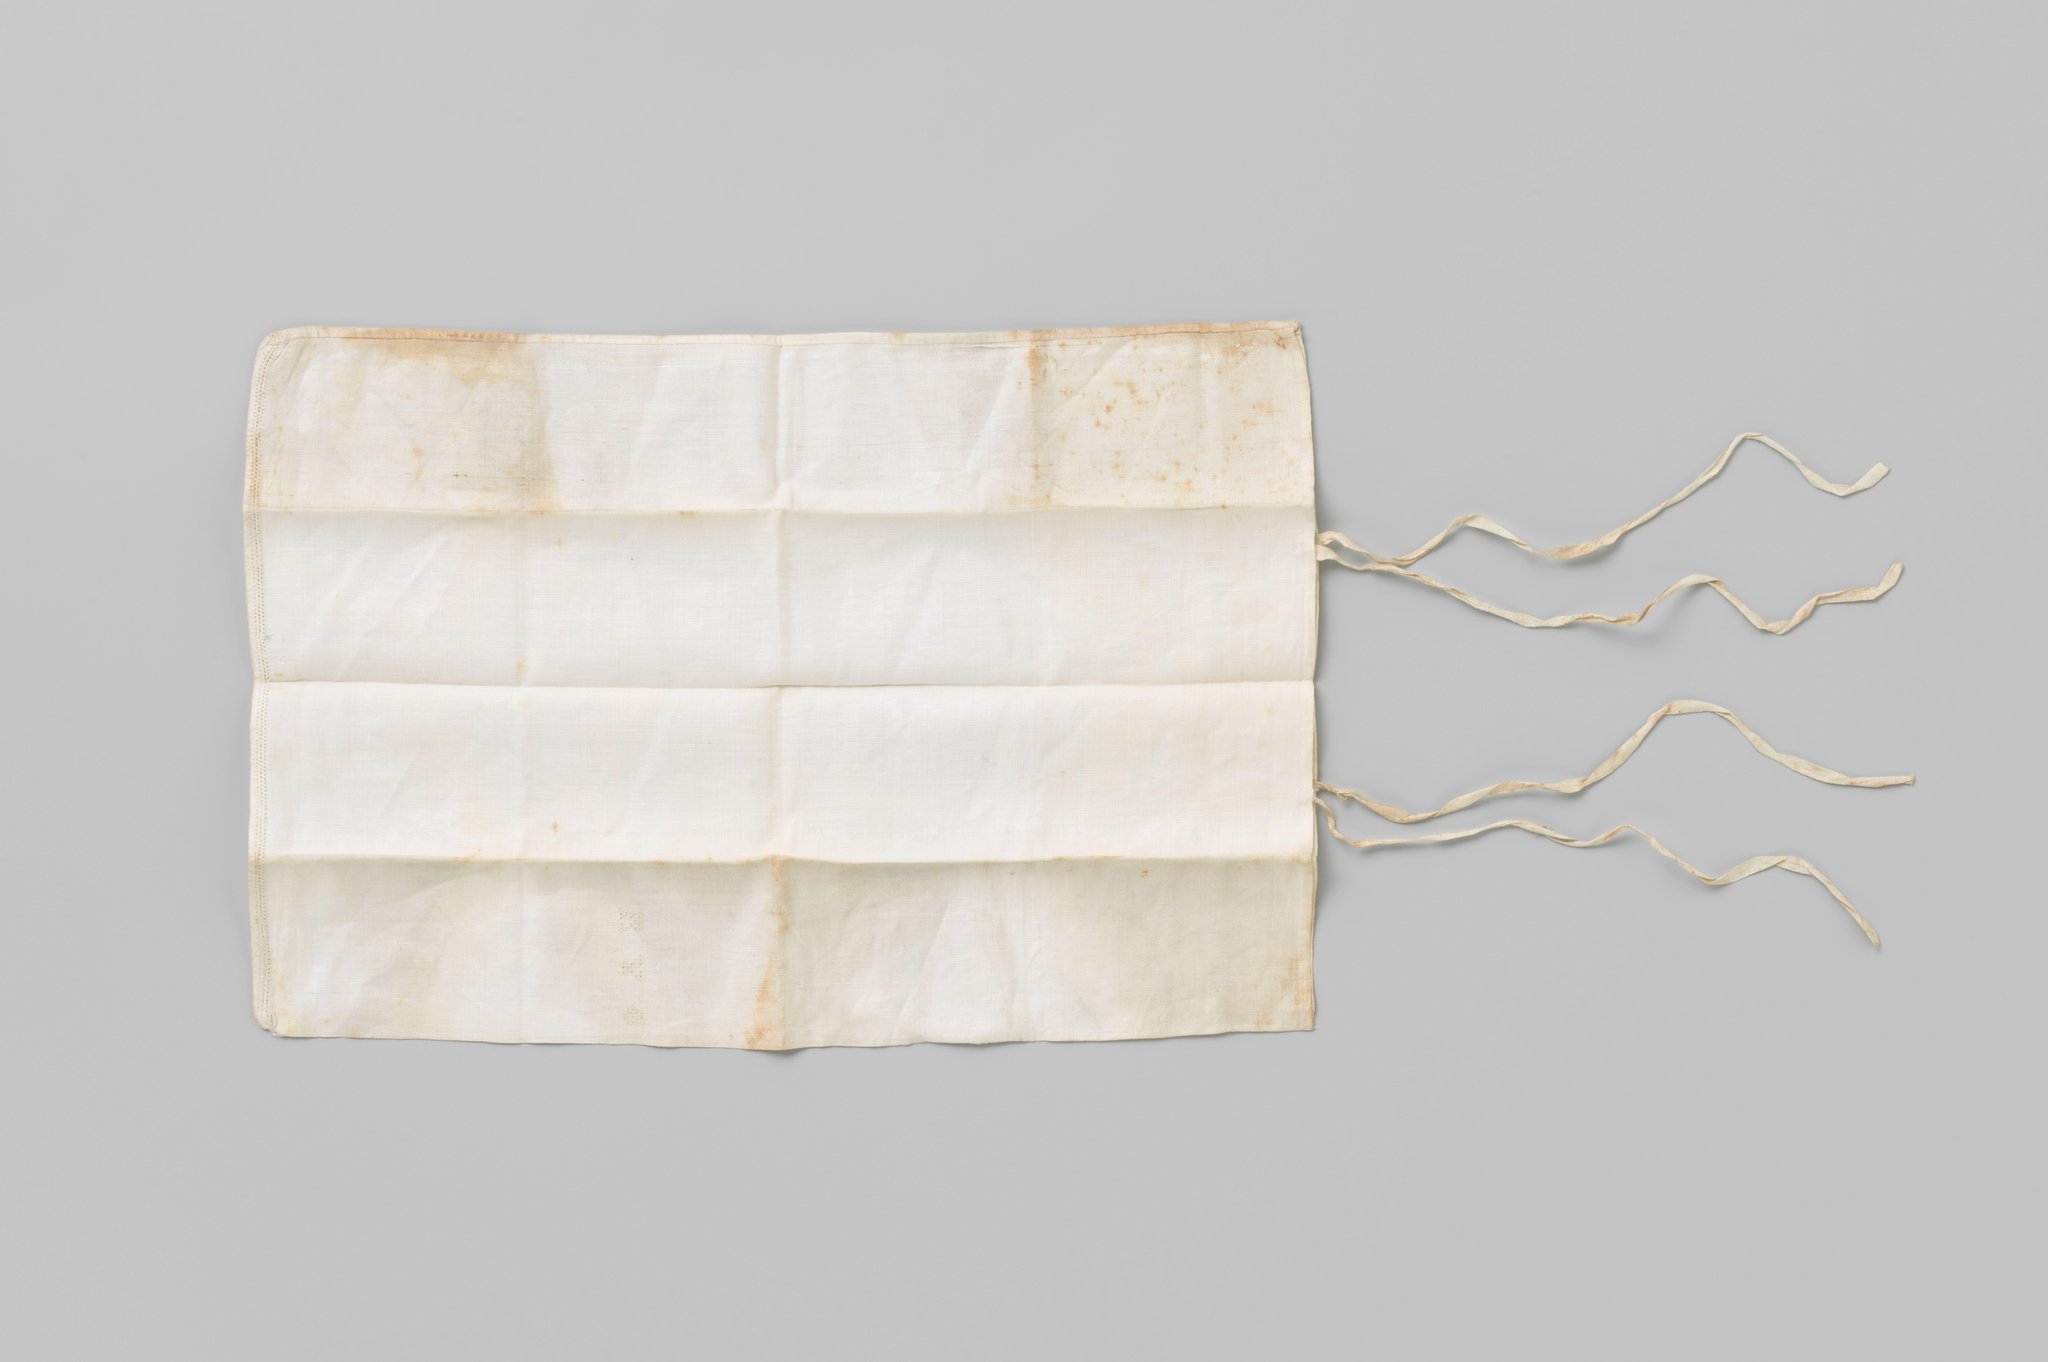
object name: lendensloop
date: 1650-1670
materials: linen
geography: northern netherlands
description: Lendensloop van linnen met open zomen, merk AVG en V en I.